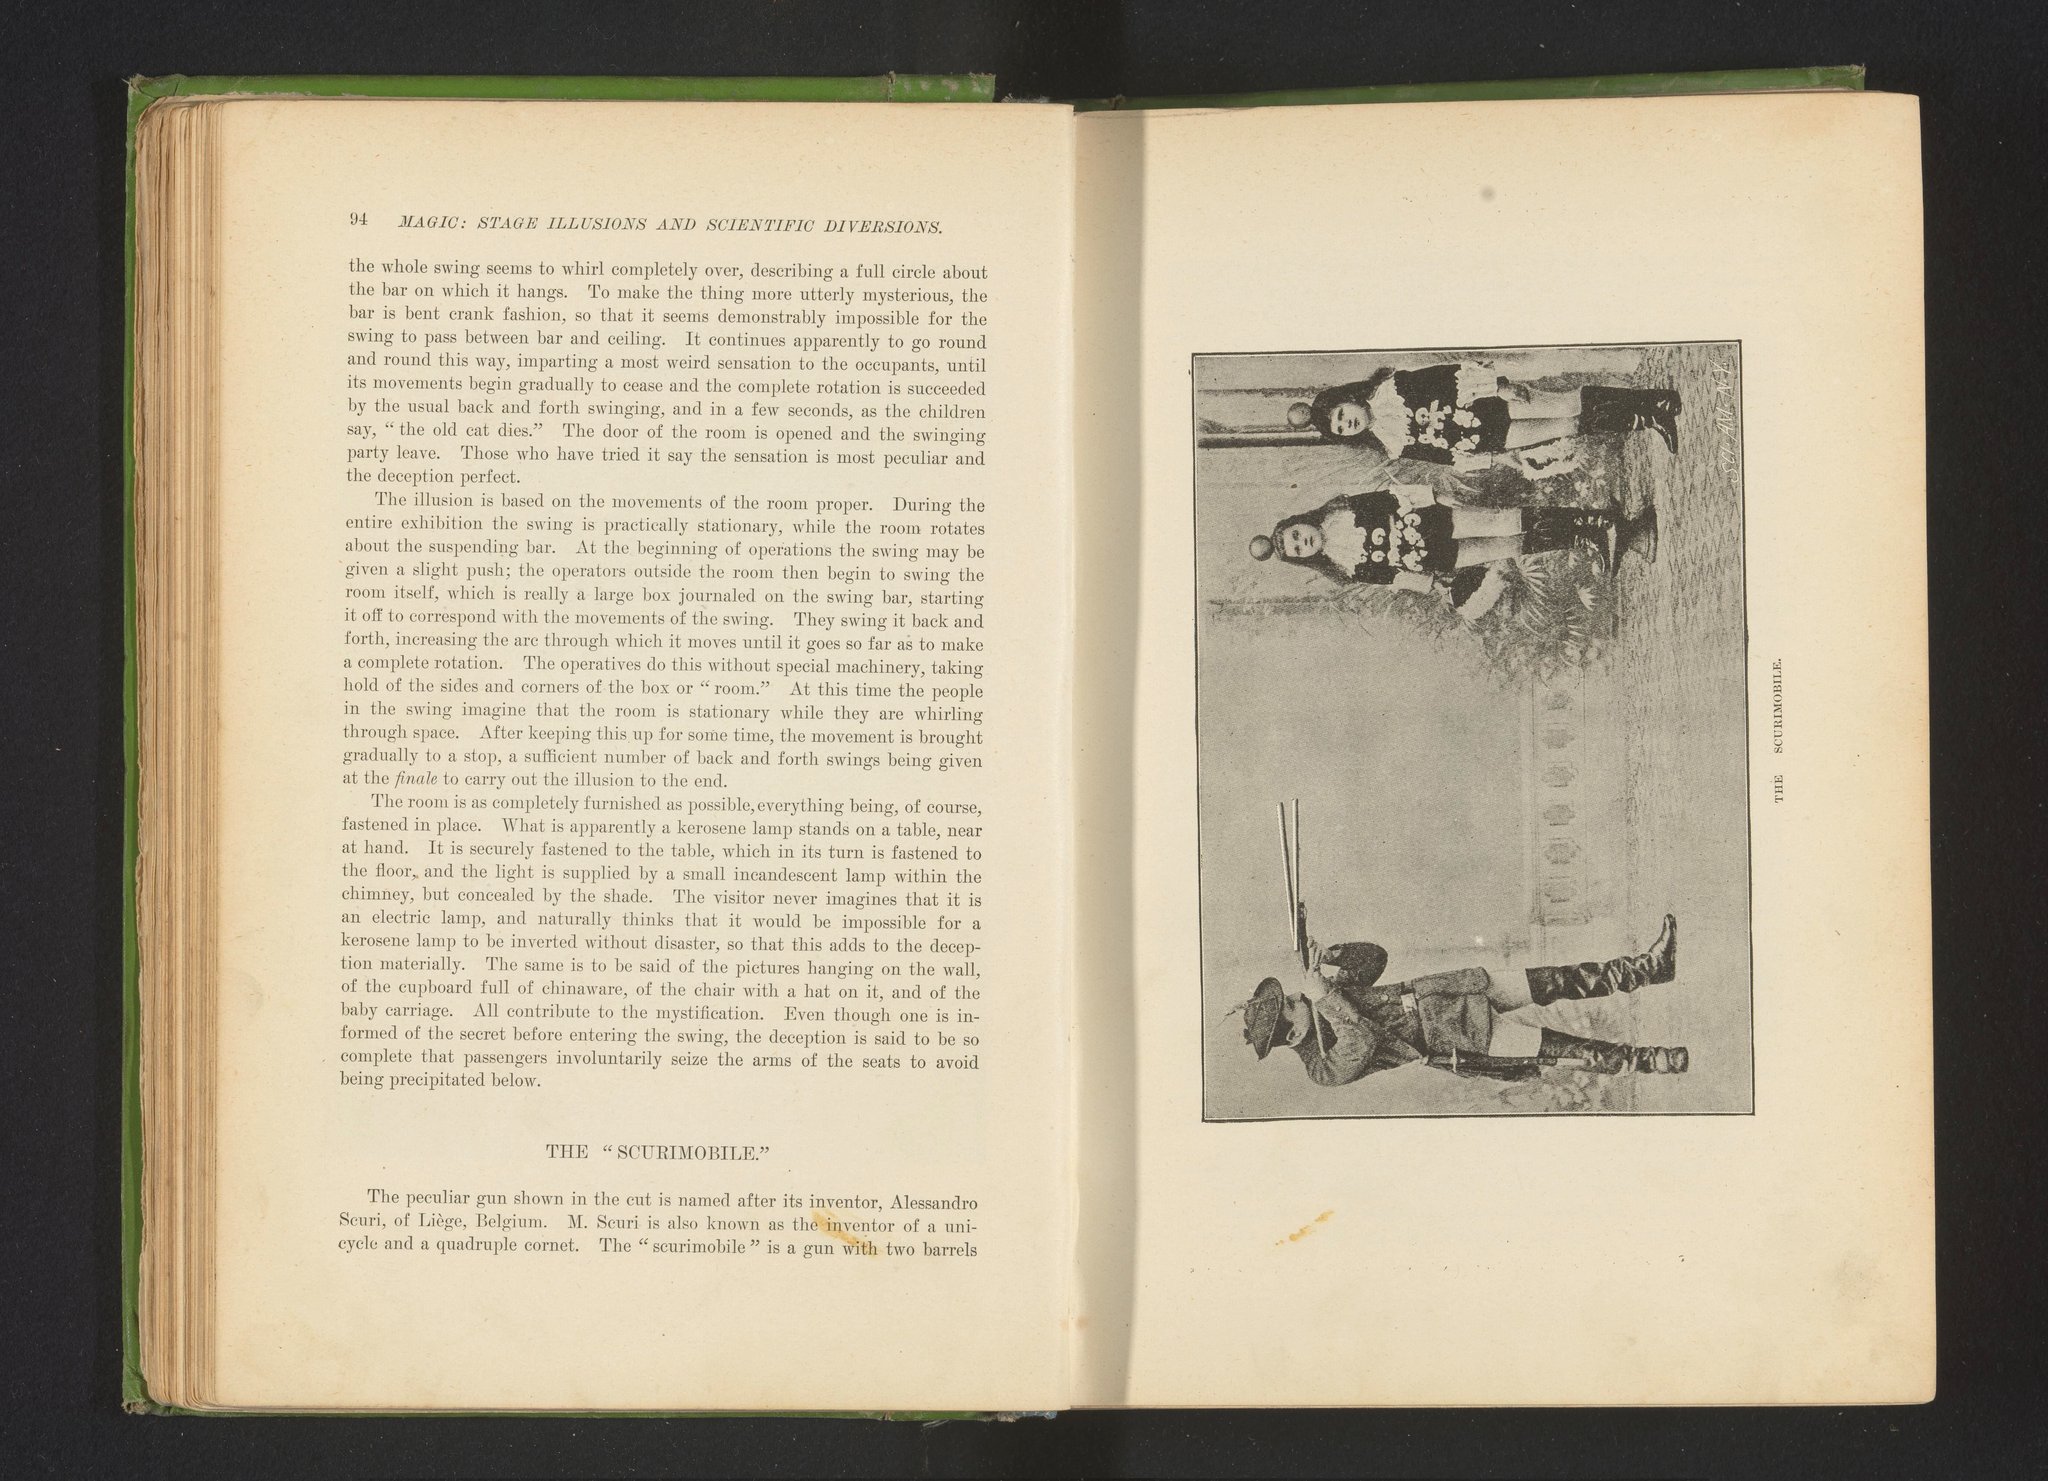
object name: photomechanical print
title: Man in kostuum richt een pistool op twee meisjes met een appel op hun hoofd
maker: Anonymous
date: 1892-1897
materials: paper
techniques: autotype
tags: fruits: apple, girl (child between toddler and youth), firearms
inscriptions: inscription: ‘SCI. AM. N.Y.’